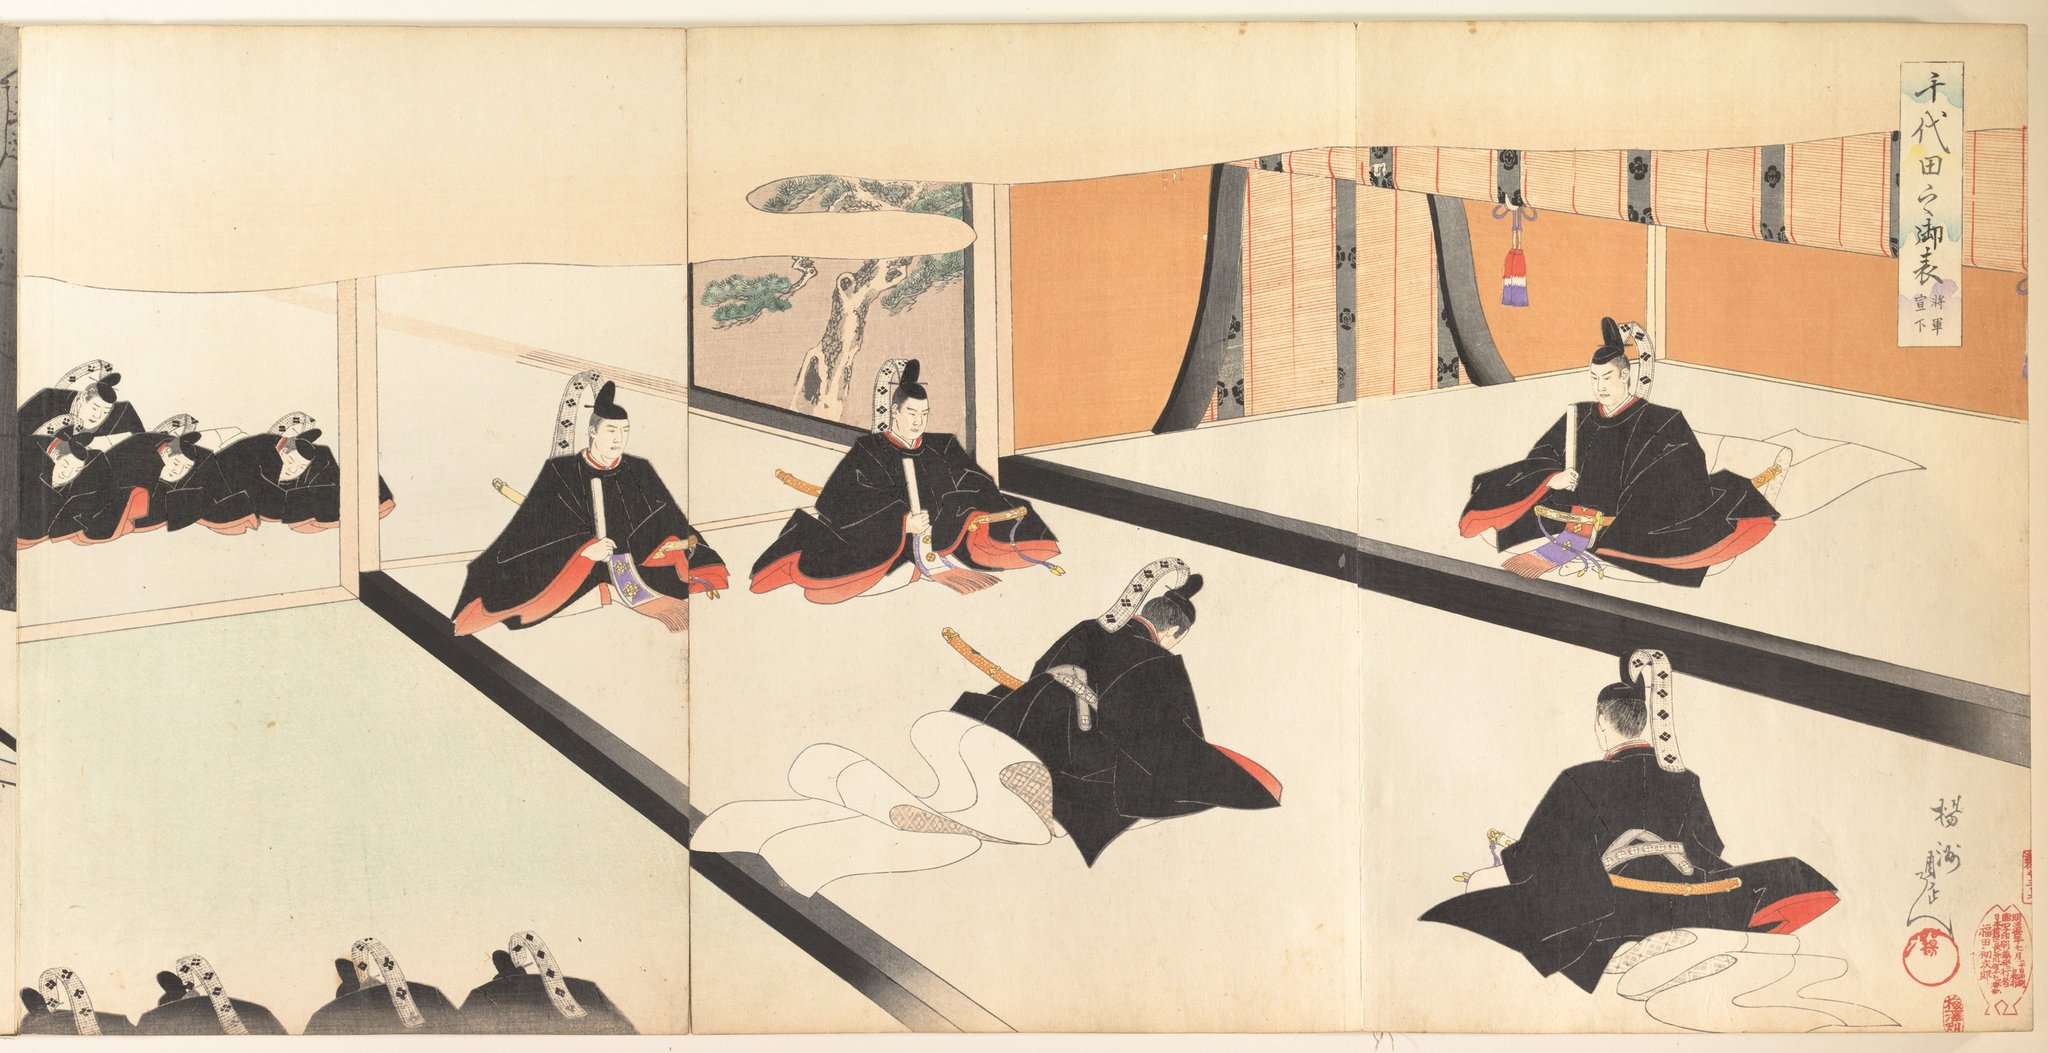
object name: print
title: Chiyoda Castle (Album of Men)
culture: japanese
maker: yōshū (hashimoto) chikanobu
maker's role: artist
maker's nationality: japanese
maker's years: 1838-1912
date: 1897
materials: ink, paper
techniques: woodblock print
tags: men